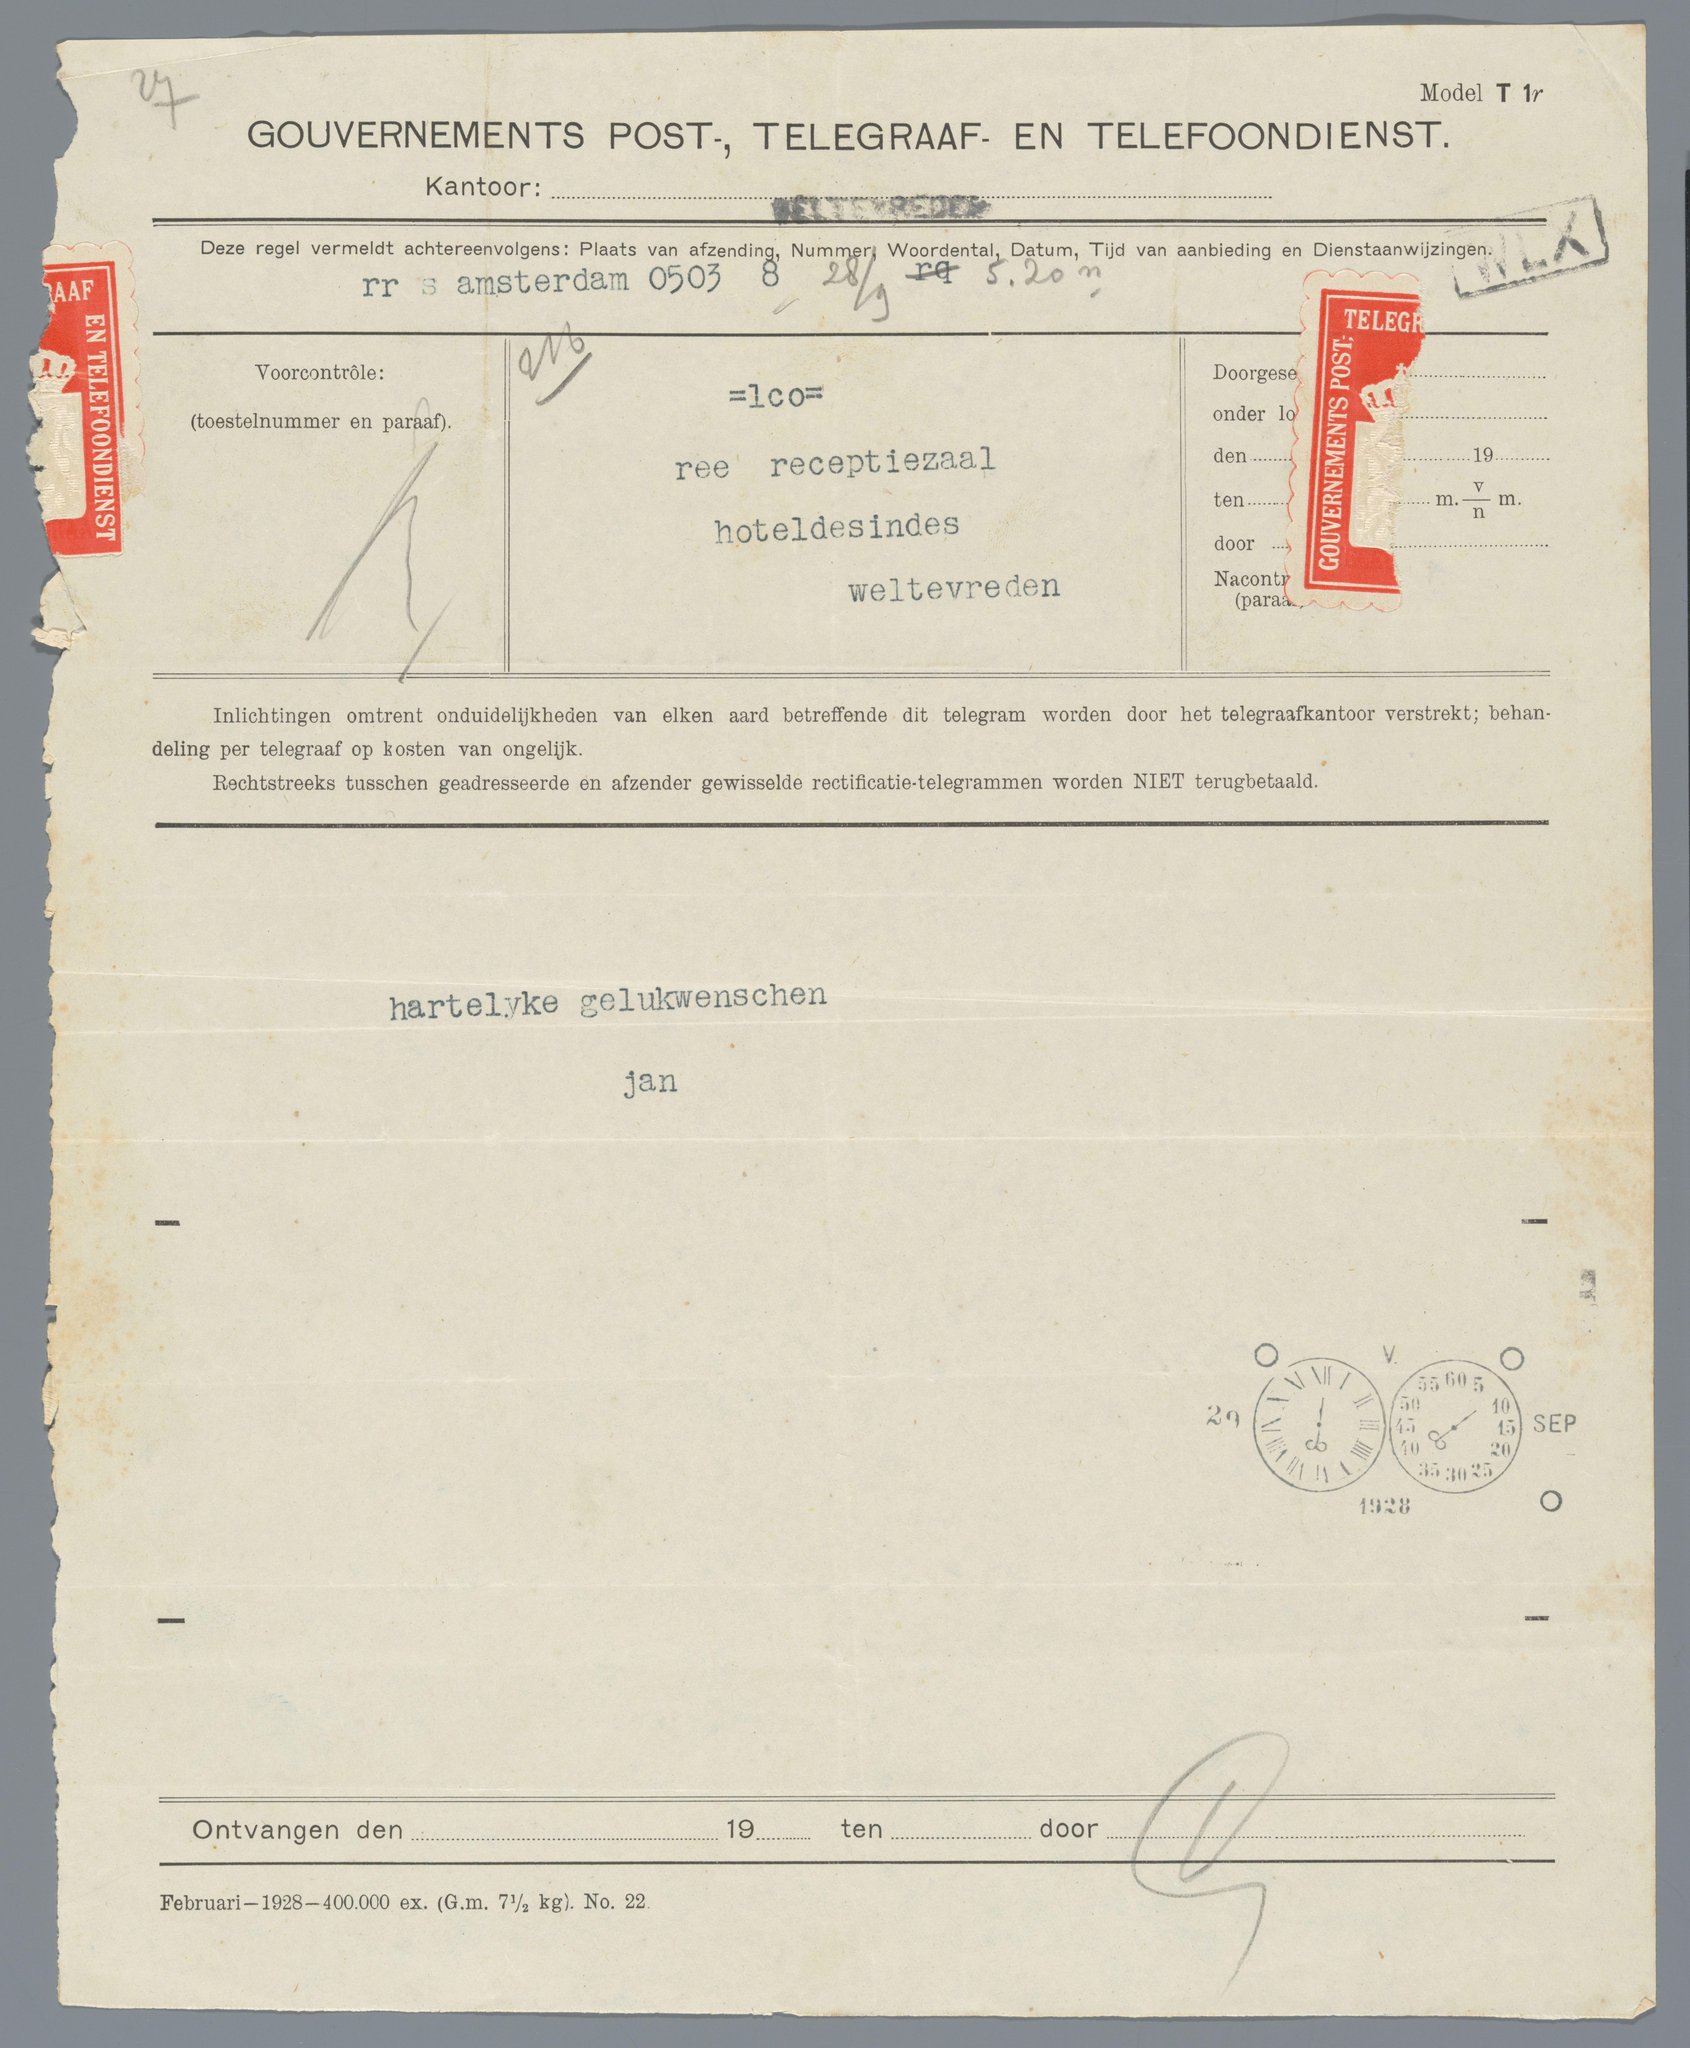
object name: telegram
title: Telegram met gelukwensen, 1928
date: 1928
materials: paper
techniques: typewriting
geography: weltevreden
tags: batavia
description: Telegram met gelukwensen namens Jan, verzonden vanuit Amsterdam op 29 september 1928. Document van Gouvernements Post-, Telegraaf- en Telefoondienst, kantoor Weltevreden, met gedrukte en getypte tekst, stempels en een verbroken zegel. Behoort bij het herinneringsalbum aangeboden aan Willem Ree van accountantsbureau Frese & Hogeweg bij zijn vertrek bij het kantoor in Weltevreden op 30 september 1928.